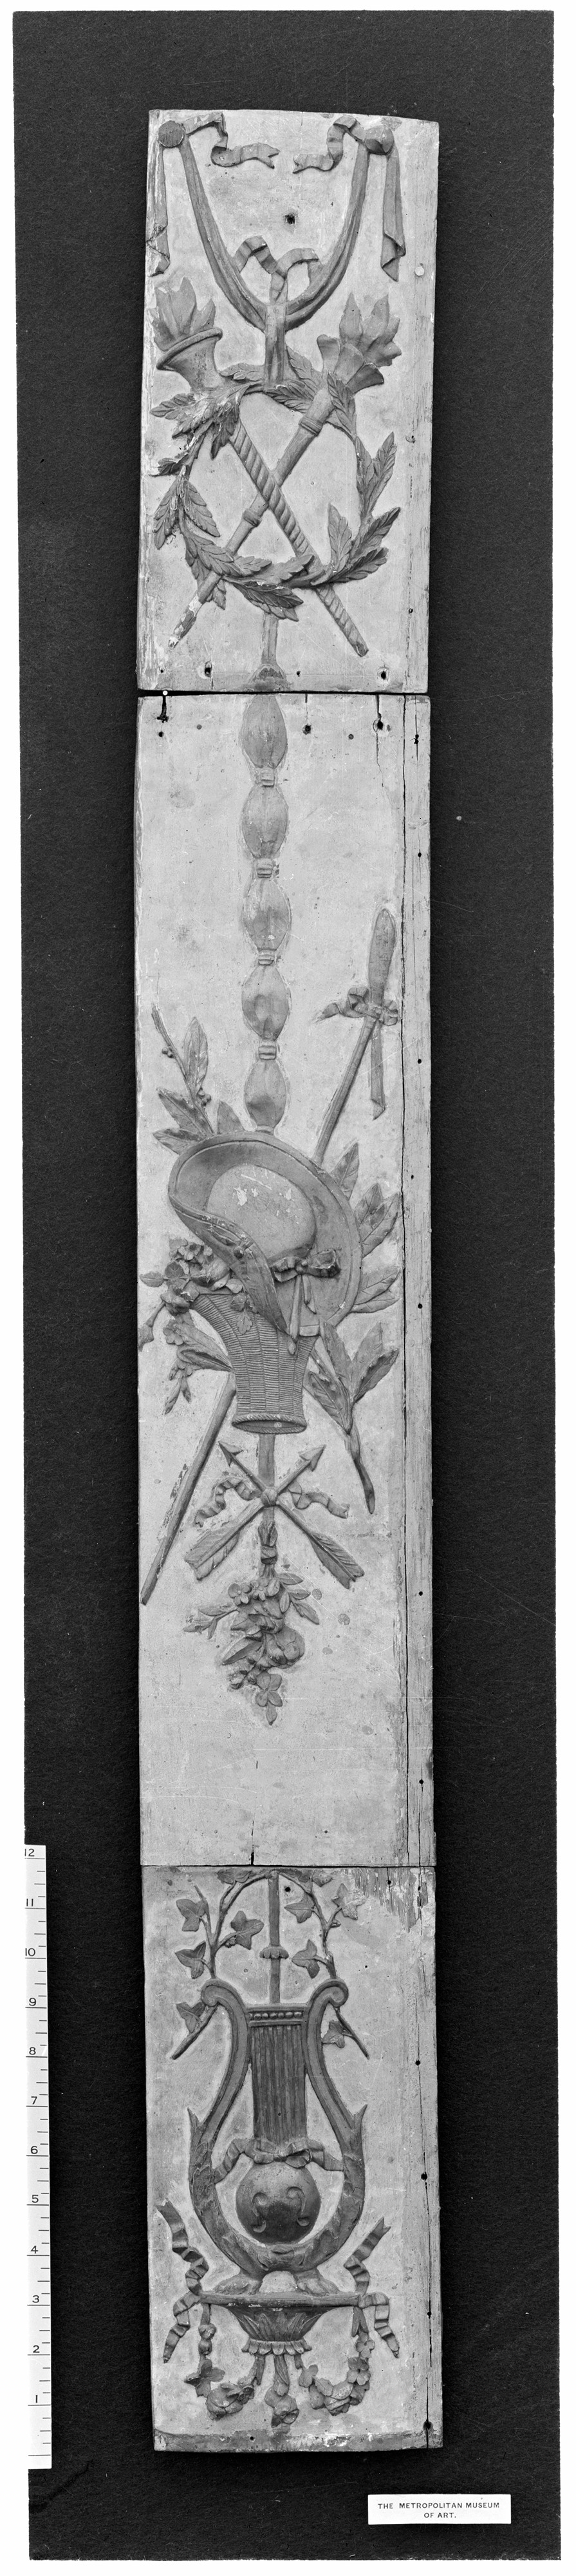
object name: panel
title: Panel formed of three smaller panels, interior decoration of the apartment of the comtesse d‘Artois at Versailles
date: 1701-1800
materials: wood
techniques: carving, gilding, painting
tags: leaves